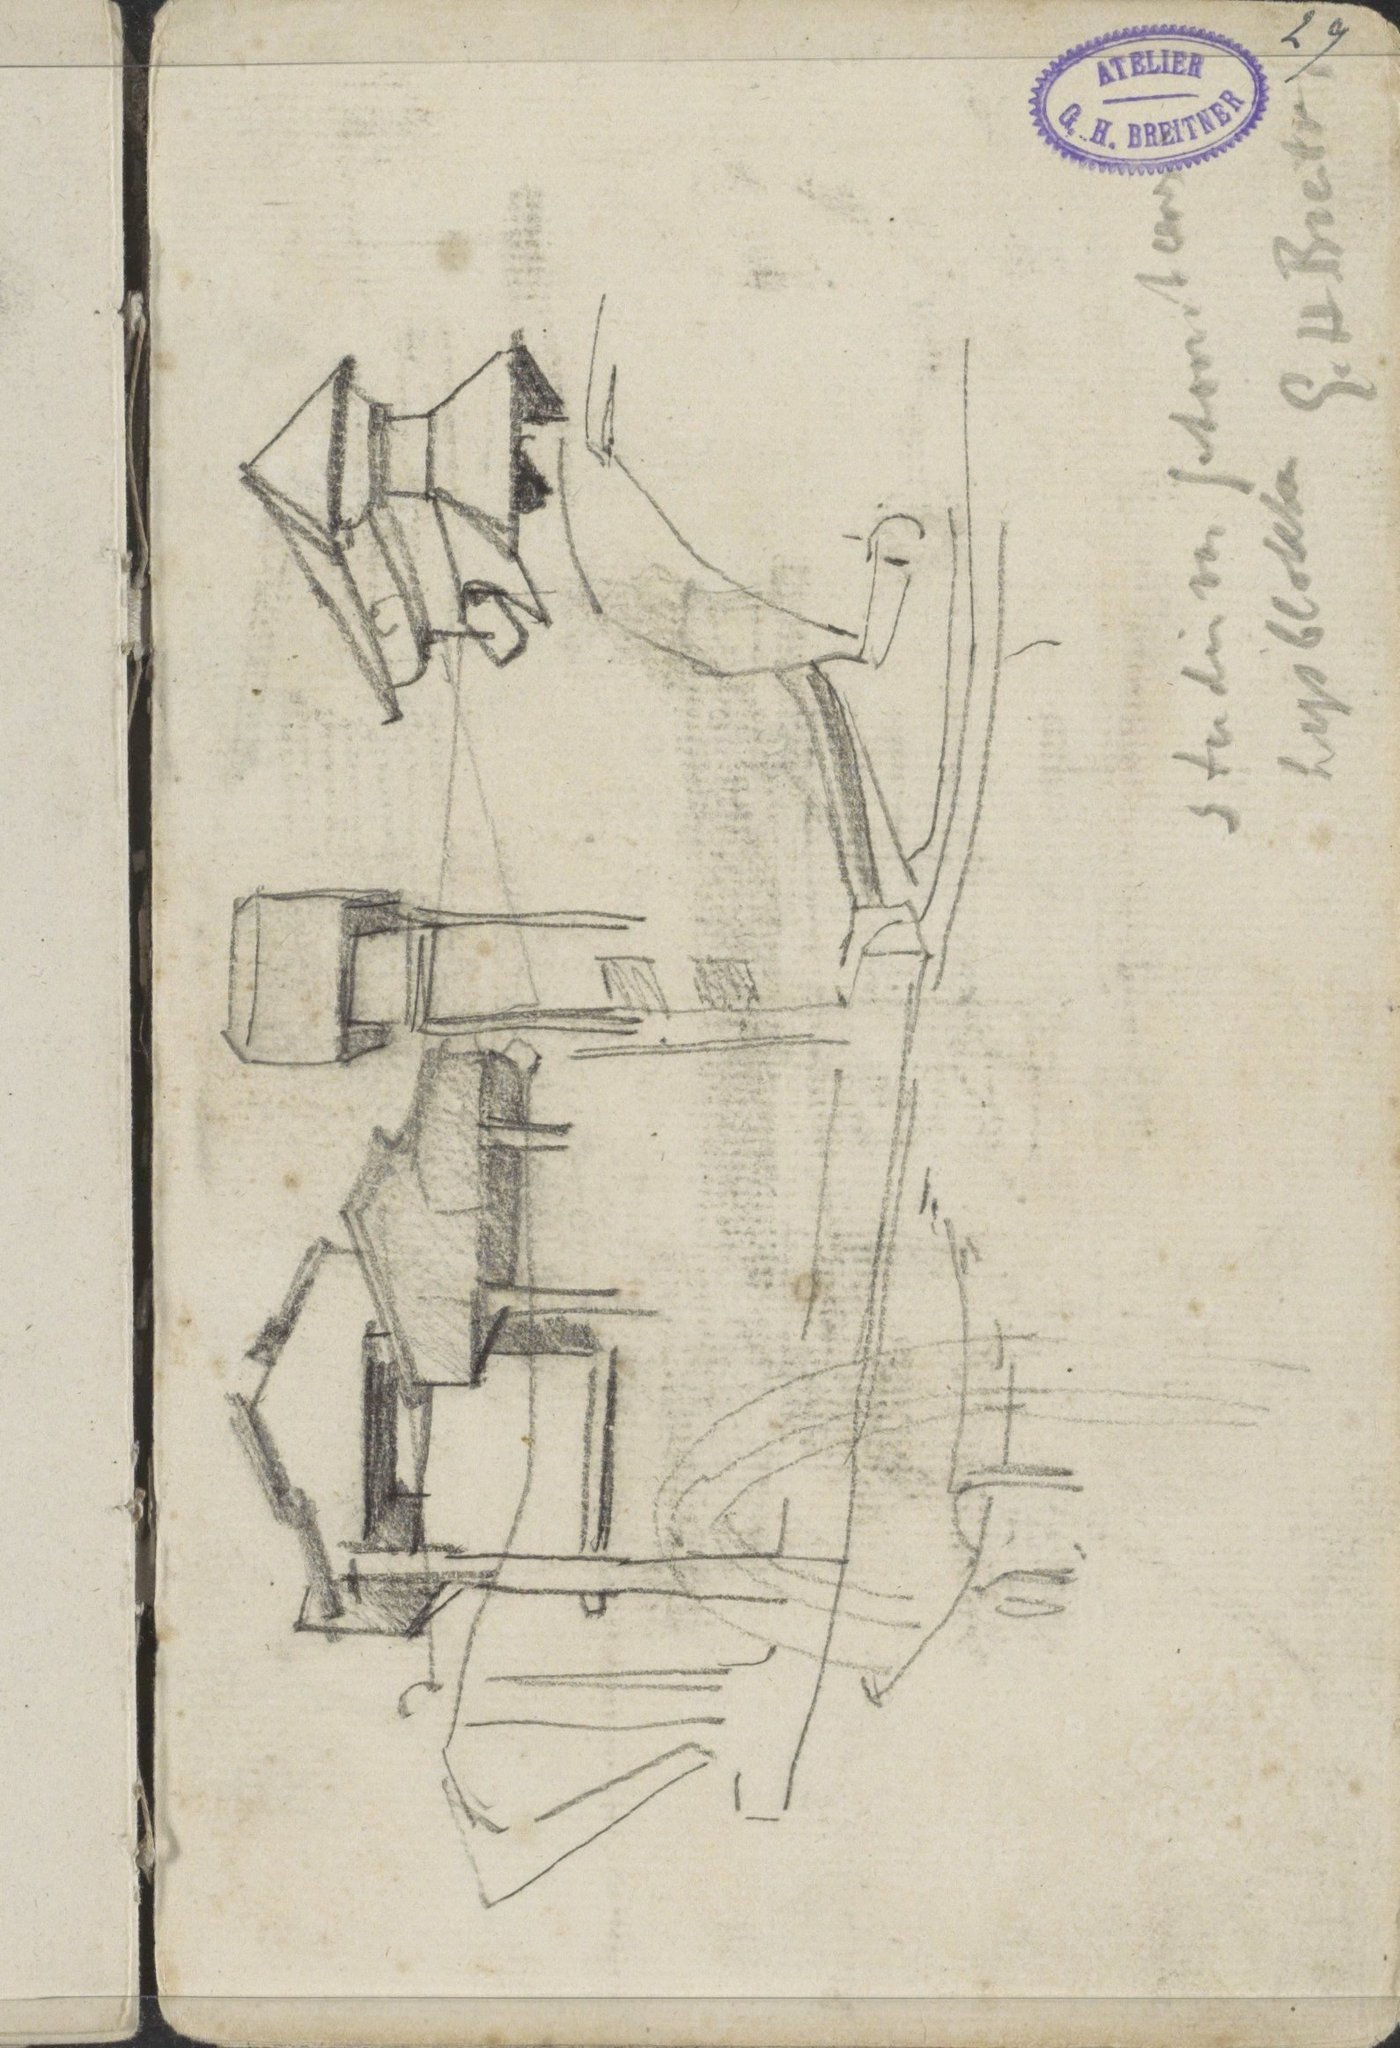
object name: sketchbook leaf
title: Studieblad met een kar, schoorstenen en hijsblokken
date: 1880-1882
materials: chalk, paper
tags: chimney, two-wheeled, animal-drawn vehicle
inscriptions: annotation: ‘Studie van schoorsteens/ hijsblokken’, signature: ‘G.H. Breitner’, workshop stamp: Lugt 291d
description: Blad 27 recto uit een schetsboek met 10 bladen.